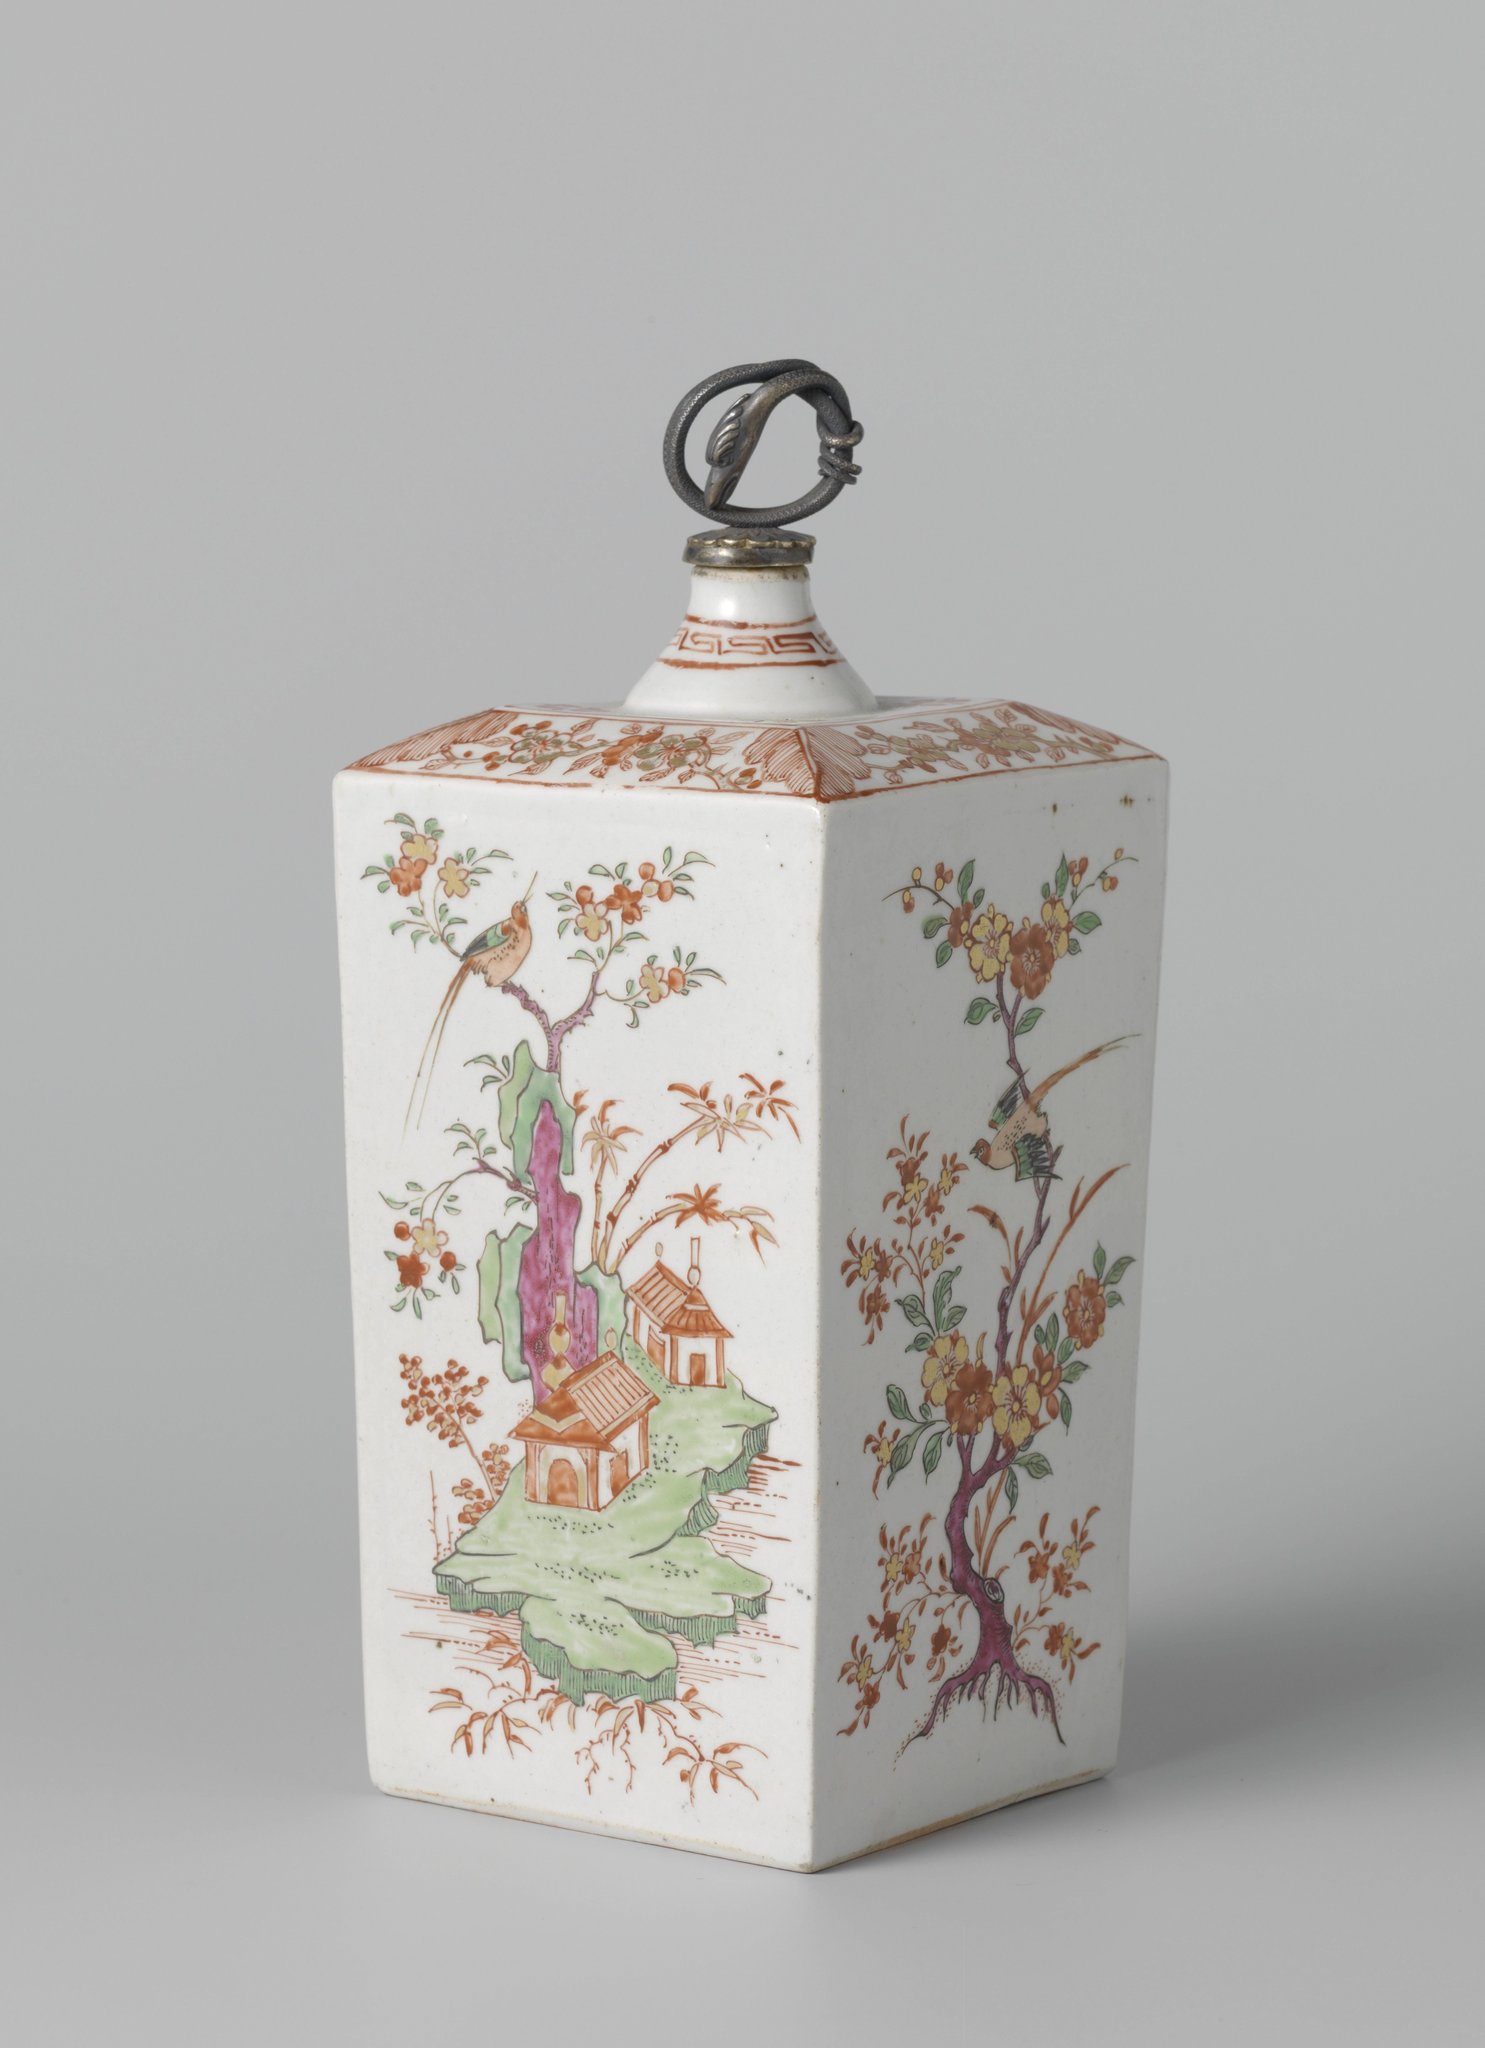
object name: bottle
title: Square bottle with birds, flowering plants and pavilions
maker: Anonymous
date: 1700-1724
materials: bronze, glaze, gold, paint, porcelain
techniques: firing, forming, gilding, vitrification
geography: europe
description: Vierkante fles van porselein met een verguld, bronzen dop, beschilderd op het glazuur in rood, groen, geel, paars, zwart en goud. Op de wanden tweemaal paviljoens op een eiland met rotsen en bloeiende planten (bamboe), een vogel op een tak, en tweemaal een vliegende vogel bij een prunustak en bamboe. Op de schouder een band met prunustakken en een bladmotief; rond de hals ranken. Op de hals een meanderpatroon. De dop is in de vorm van een gevlochten ring, eindigend in een hoo-vogelkop op een bloemrozet. De rand is afgeslepen. Arita, in Europa gedecoreerd[?] in de Japanse Kakiemon-stijl.